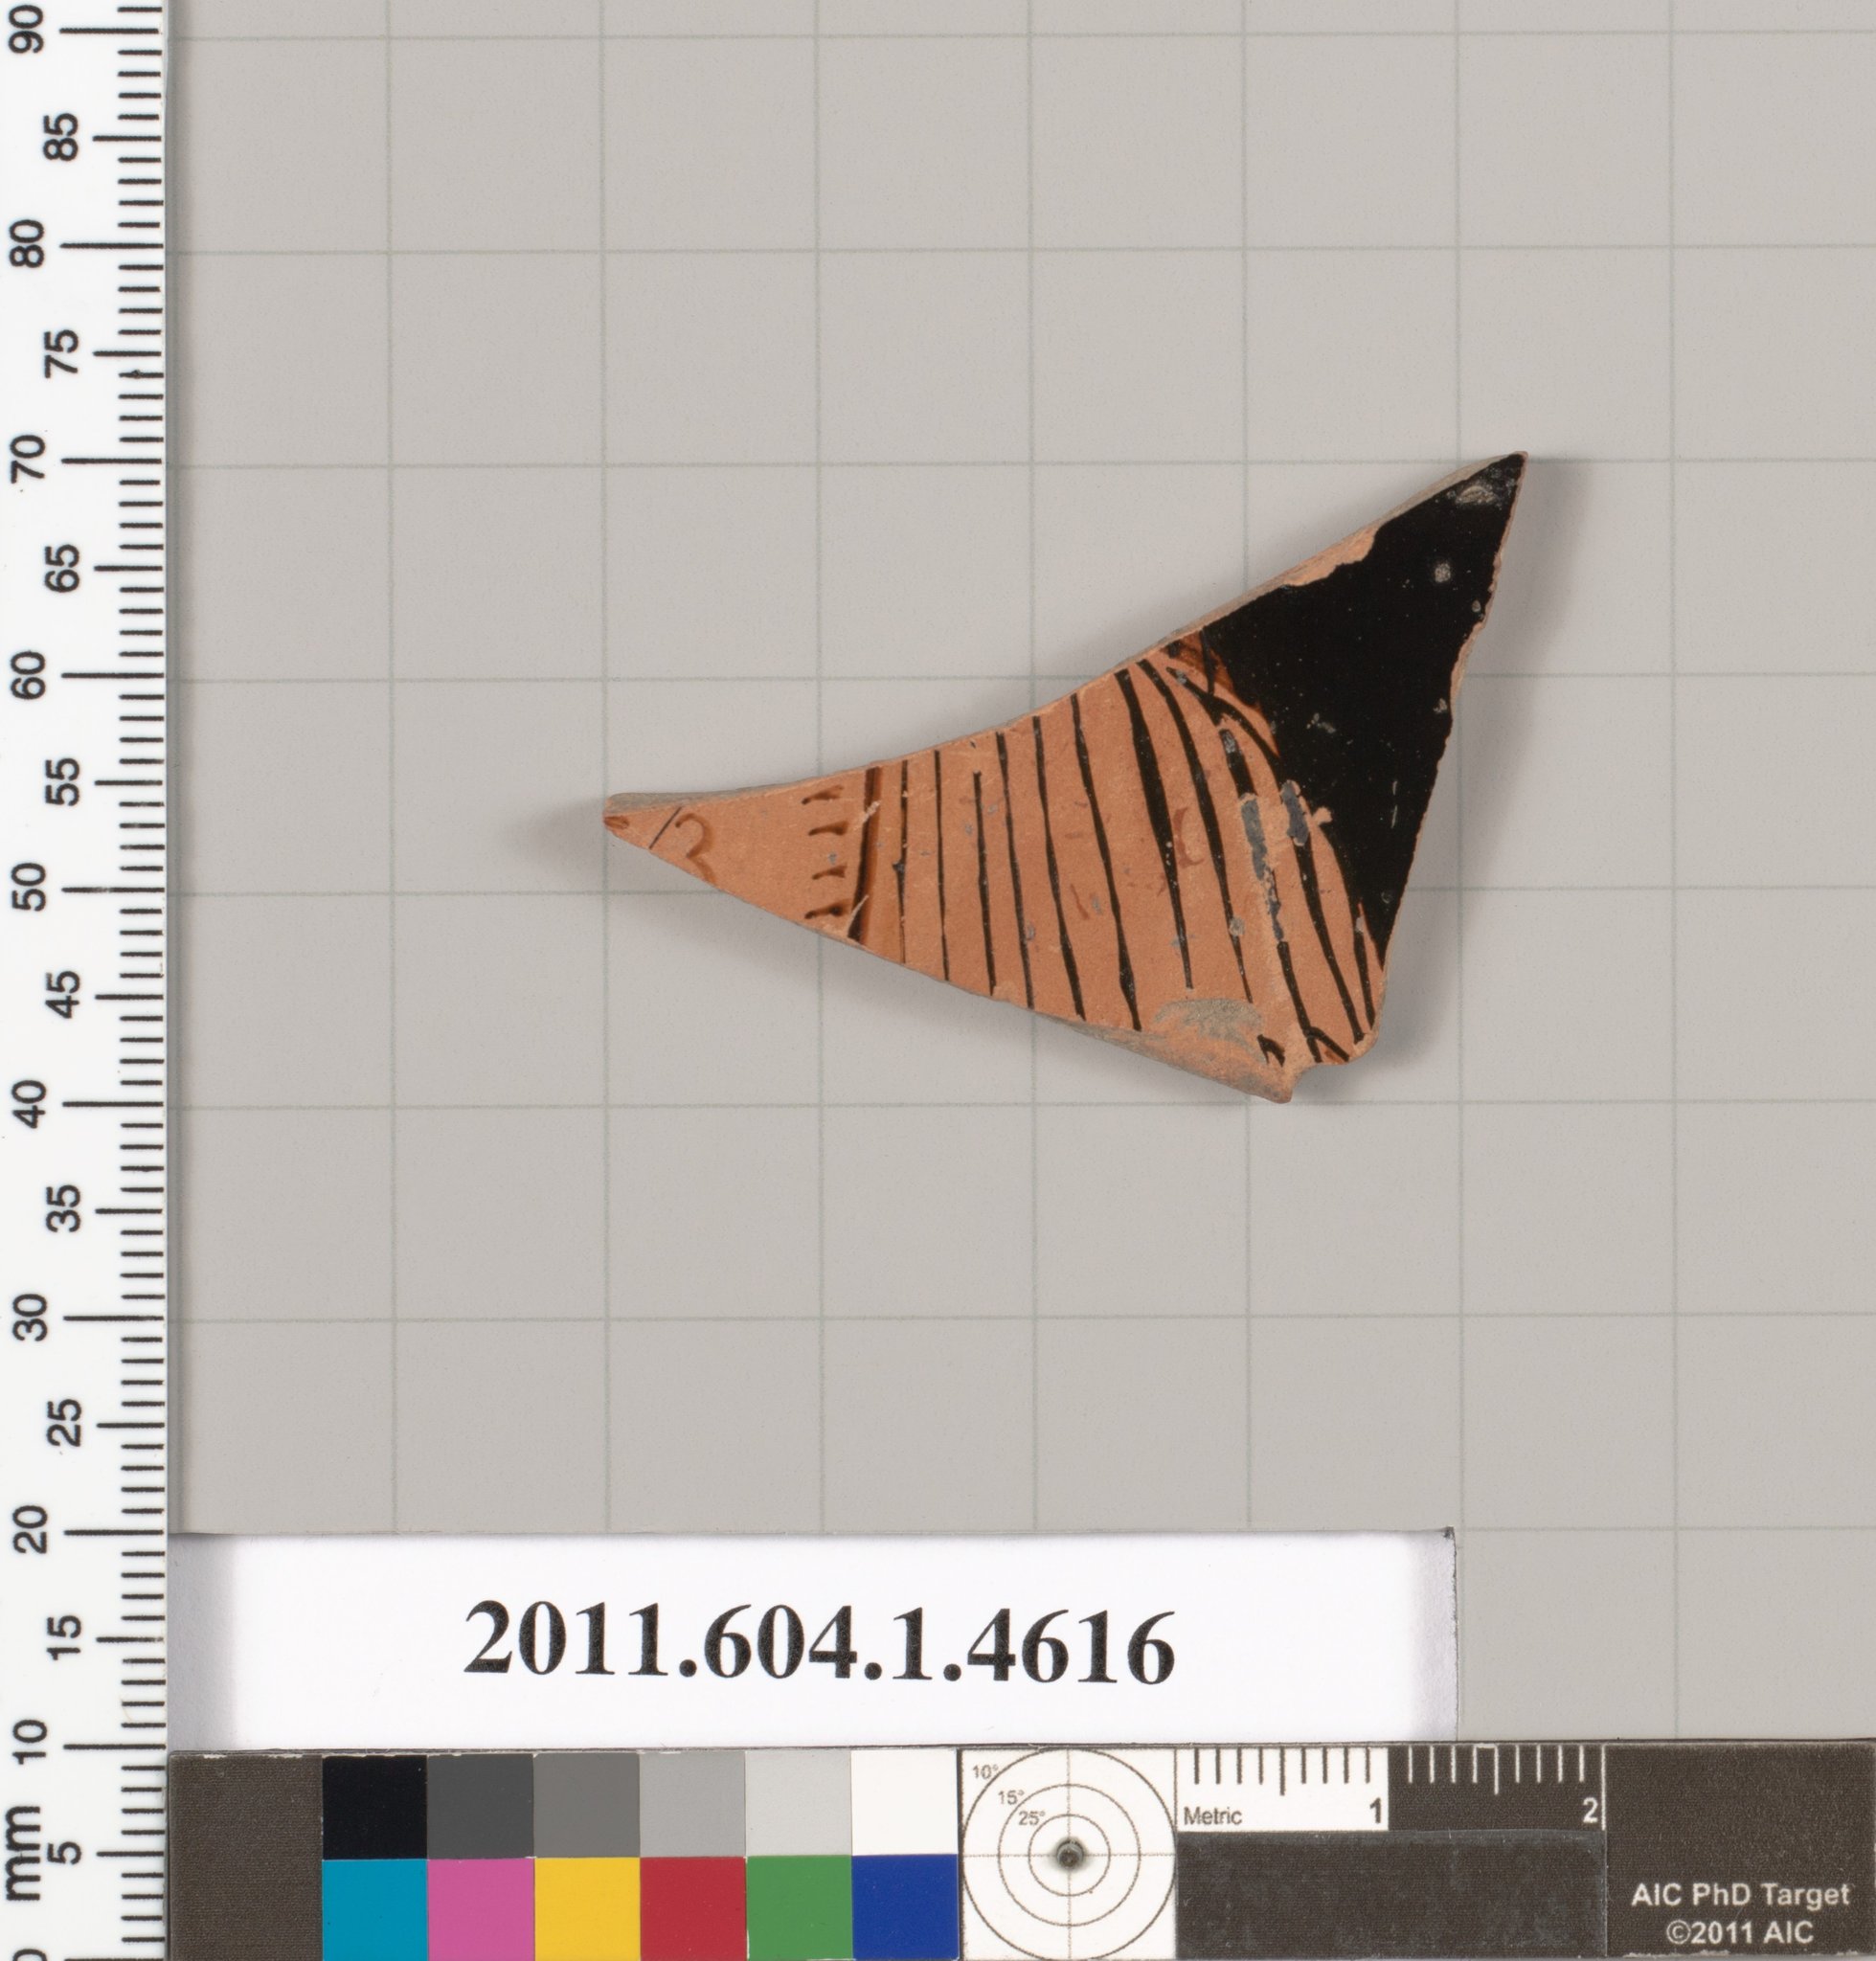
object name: kylix fragment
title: Terracotta fragment of a kylix (drinking cup)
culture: greek, attic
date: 490-470 BCE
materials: terracotta